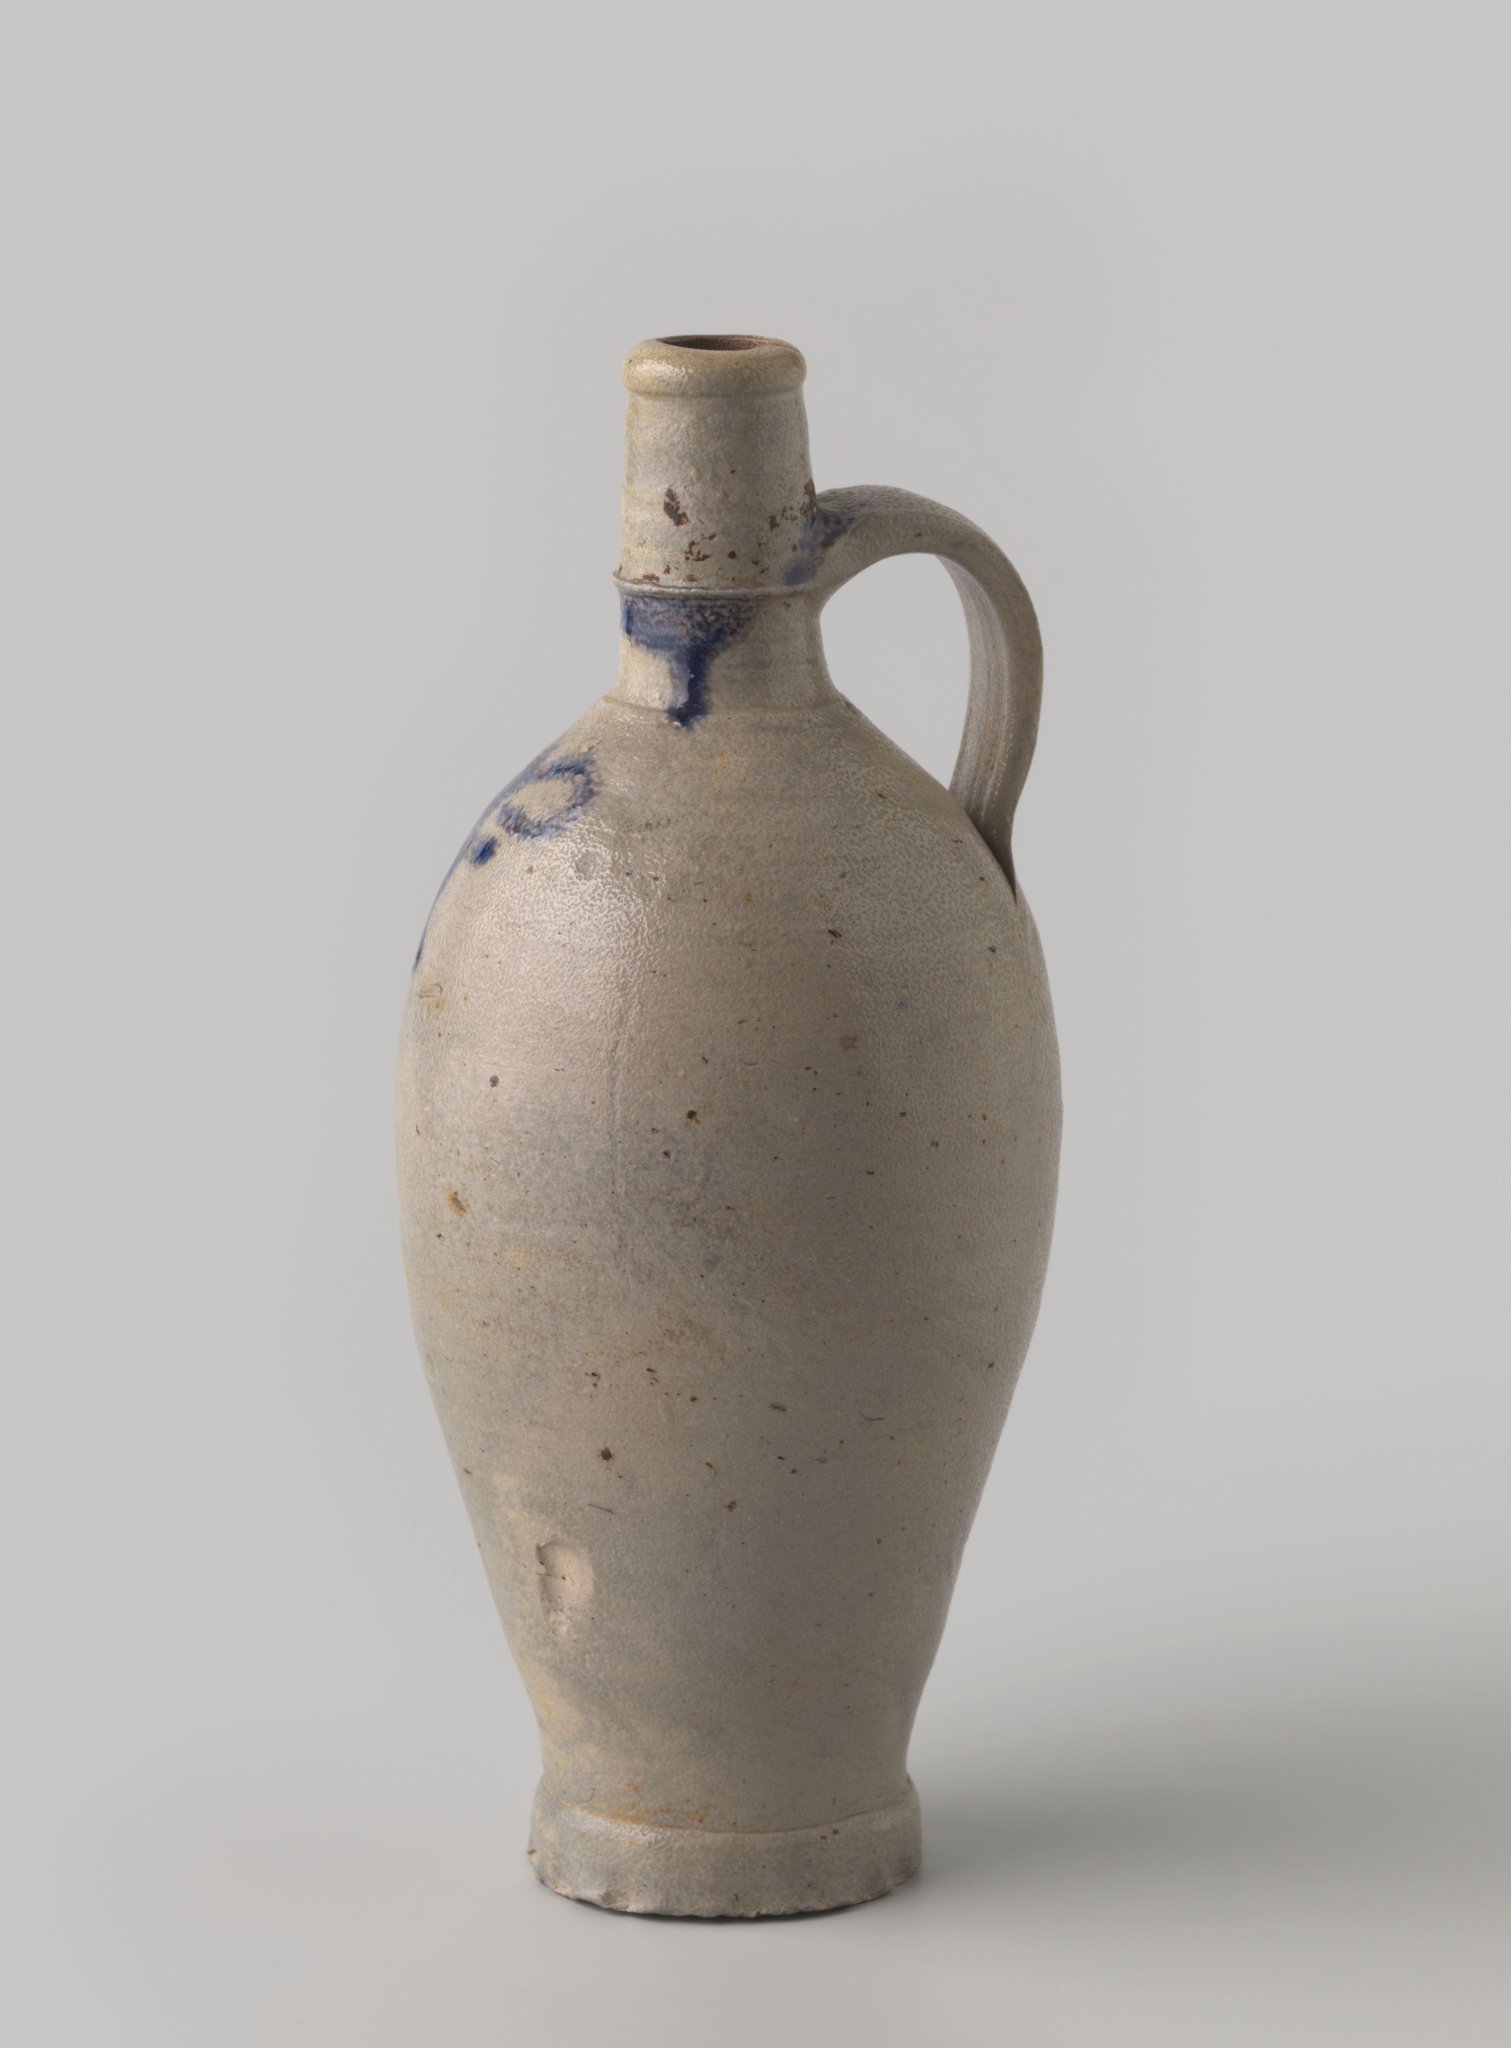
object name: jug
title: Smalle hoge kruik van steengoed met oor, voorzien van kleurloos glazuur met een kleine decoratie in blauw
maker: Anonymous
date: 1600-1650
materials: glaze, stoneware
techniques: maiolica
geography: northern netherlands